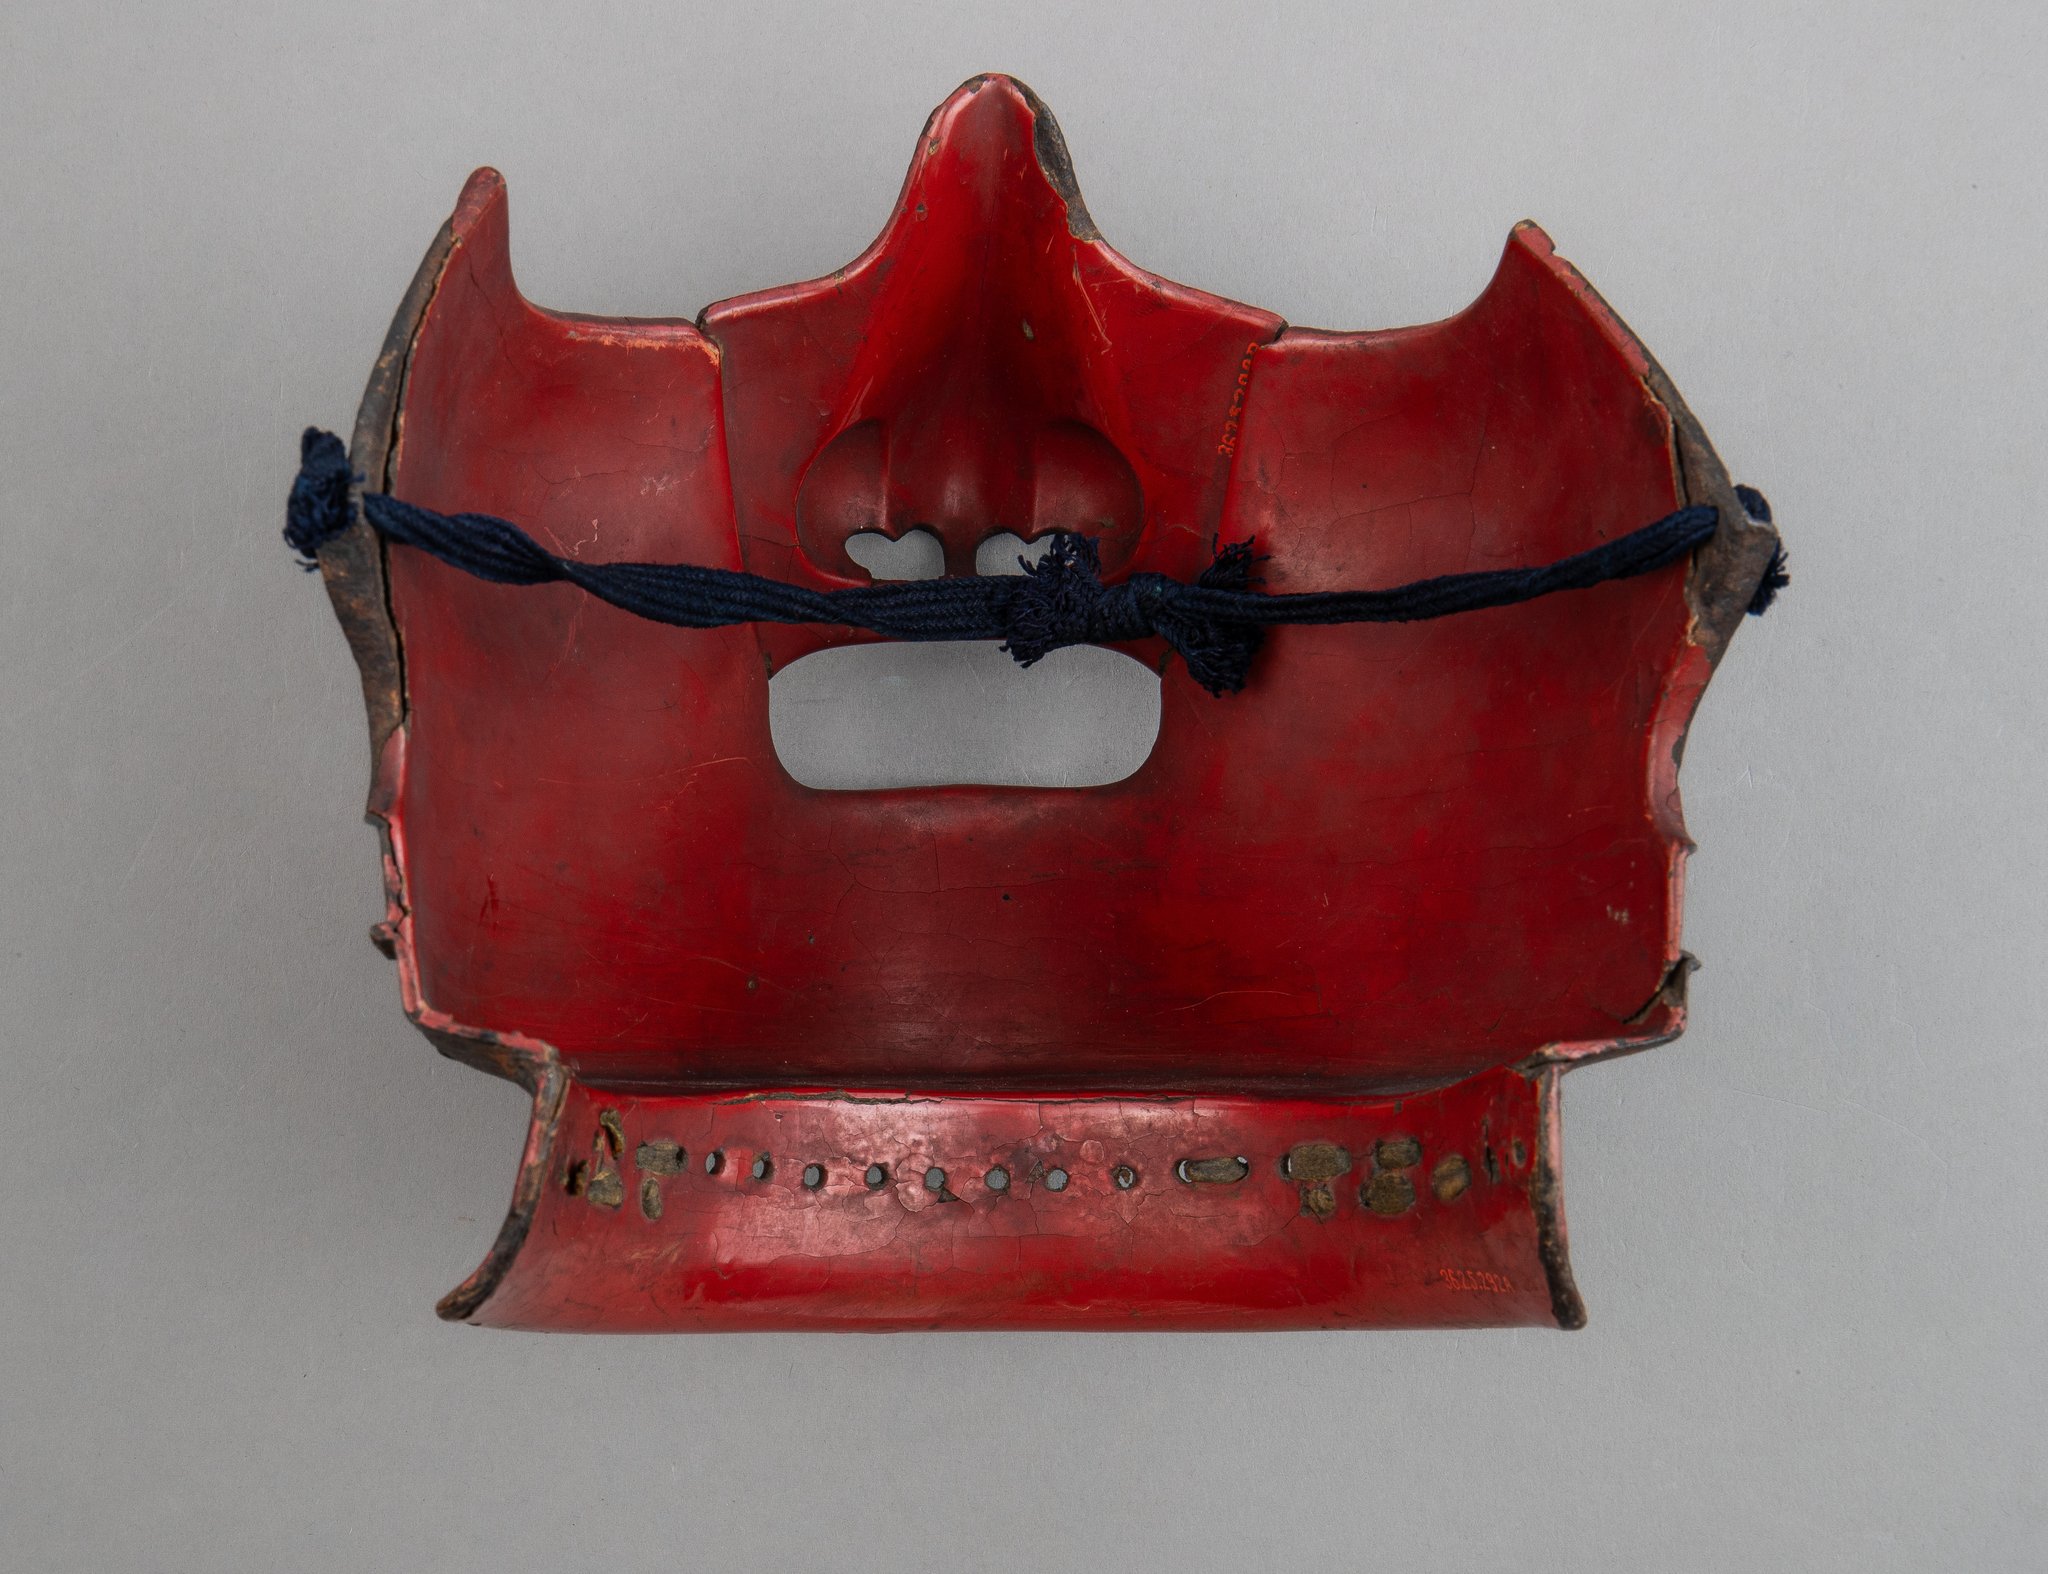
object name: half mask menpō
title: Half Mask (Menpō)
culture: japanese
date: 1615-1868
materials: iron, lacquer, leather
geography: japan